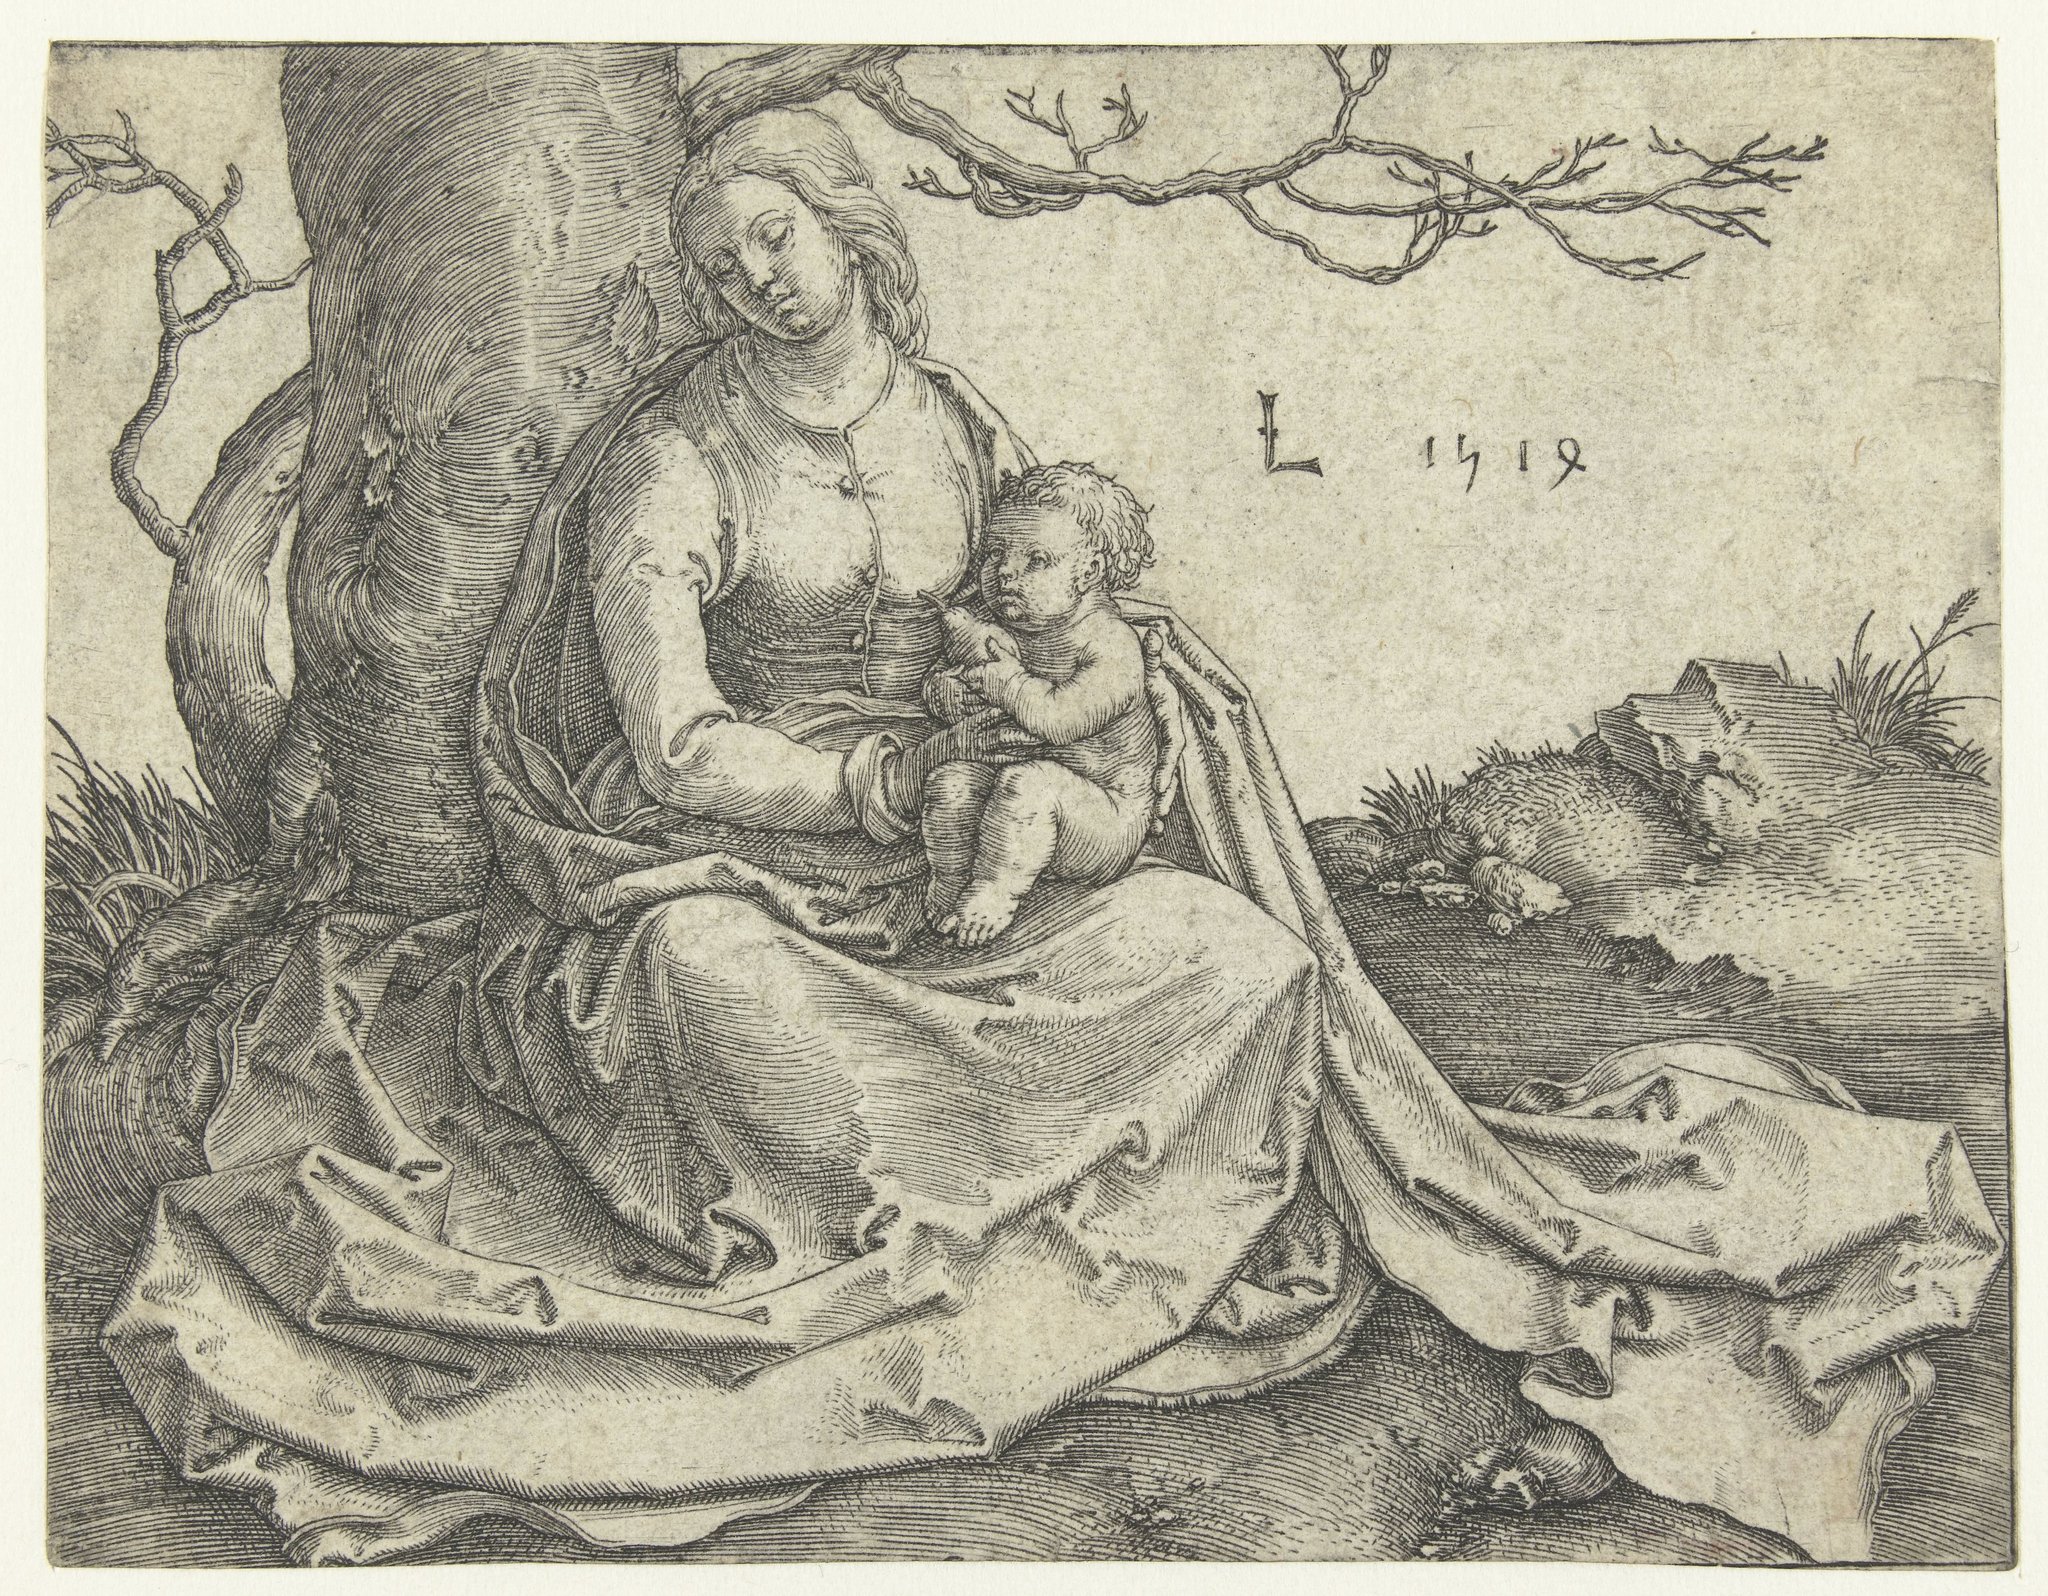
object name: print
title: Virgin and Child Seated under a Tree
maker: lucas van leyden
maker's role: draughtsman, painter, print maker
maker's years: 1494-1533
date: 1514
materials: paper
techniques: engraving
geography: low countries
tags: mary sitting on the ground, the christ-child in front of her in her lap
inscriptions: collector's mark: Lugt 240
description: Landscape plays an important role in the three engravings on view. Here, however, Lucas decided not to work out the background in detail: all attention is focussed on the confident rendering of the delicately elaborated figures. The folds of Mary’s gown are busier and more angular than in the engraving of 1508. The pronounced highlights on the folds are a feature that recurs in the painting Virgin and Child.